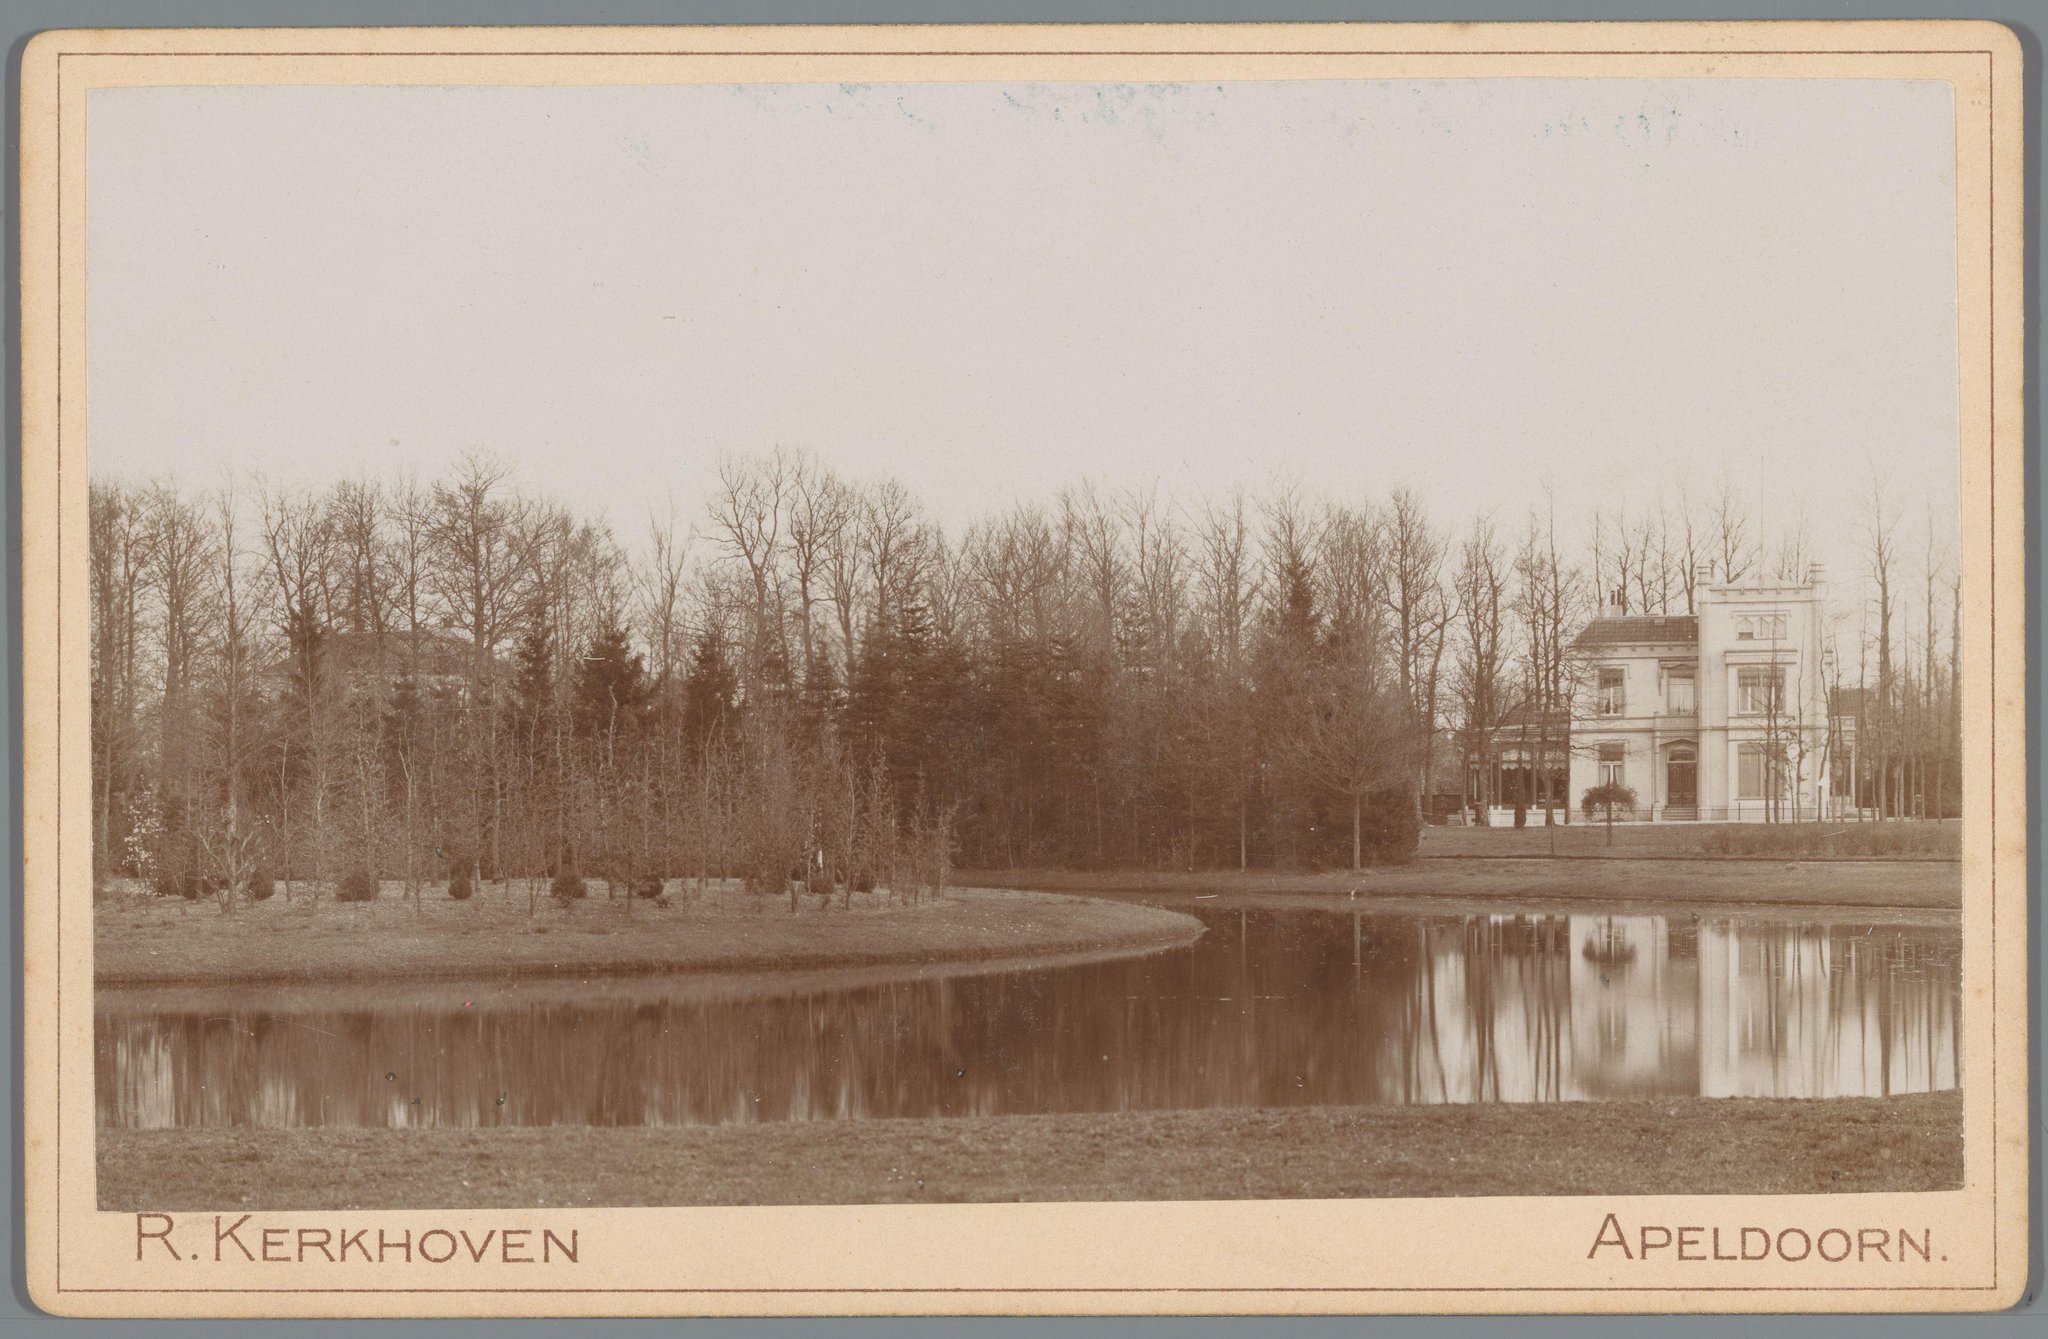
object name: cabinet photograph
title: Oranjepark in Apeldoorn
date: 1893-1902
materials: paper, cardboard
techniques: collodion silver print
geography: apeldoorn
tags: park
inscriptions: stamp: ‘A.F. van Wieringen/ Boek-, Muziek-/ & Kunsthandel/ Apeldoorn’, collector's mark: ‘Vosmaer’